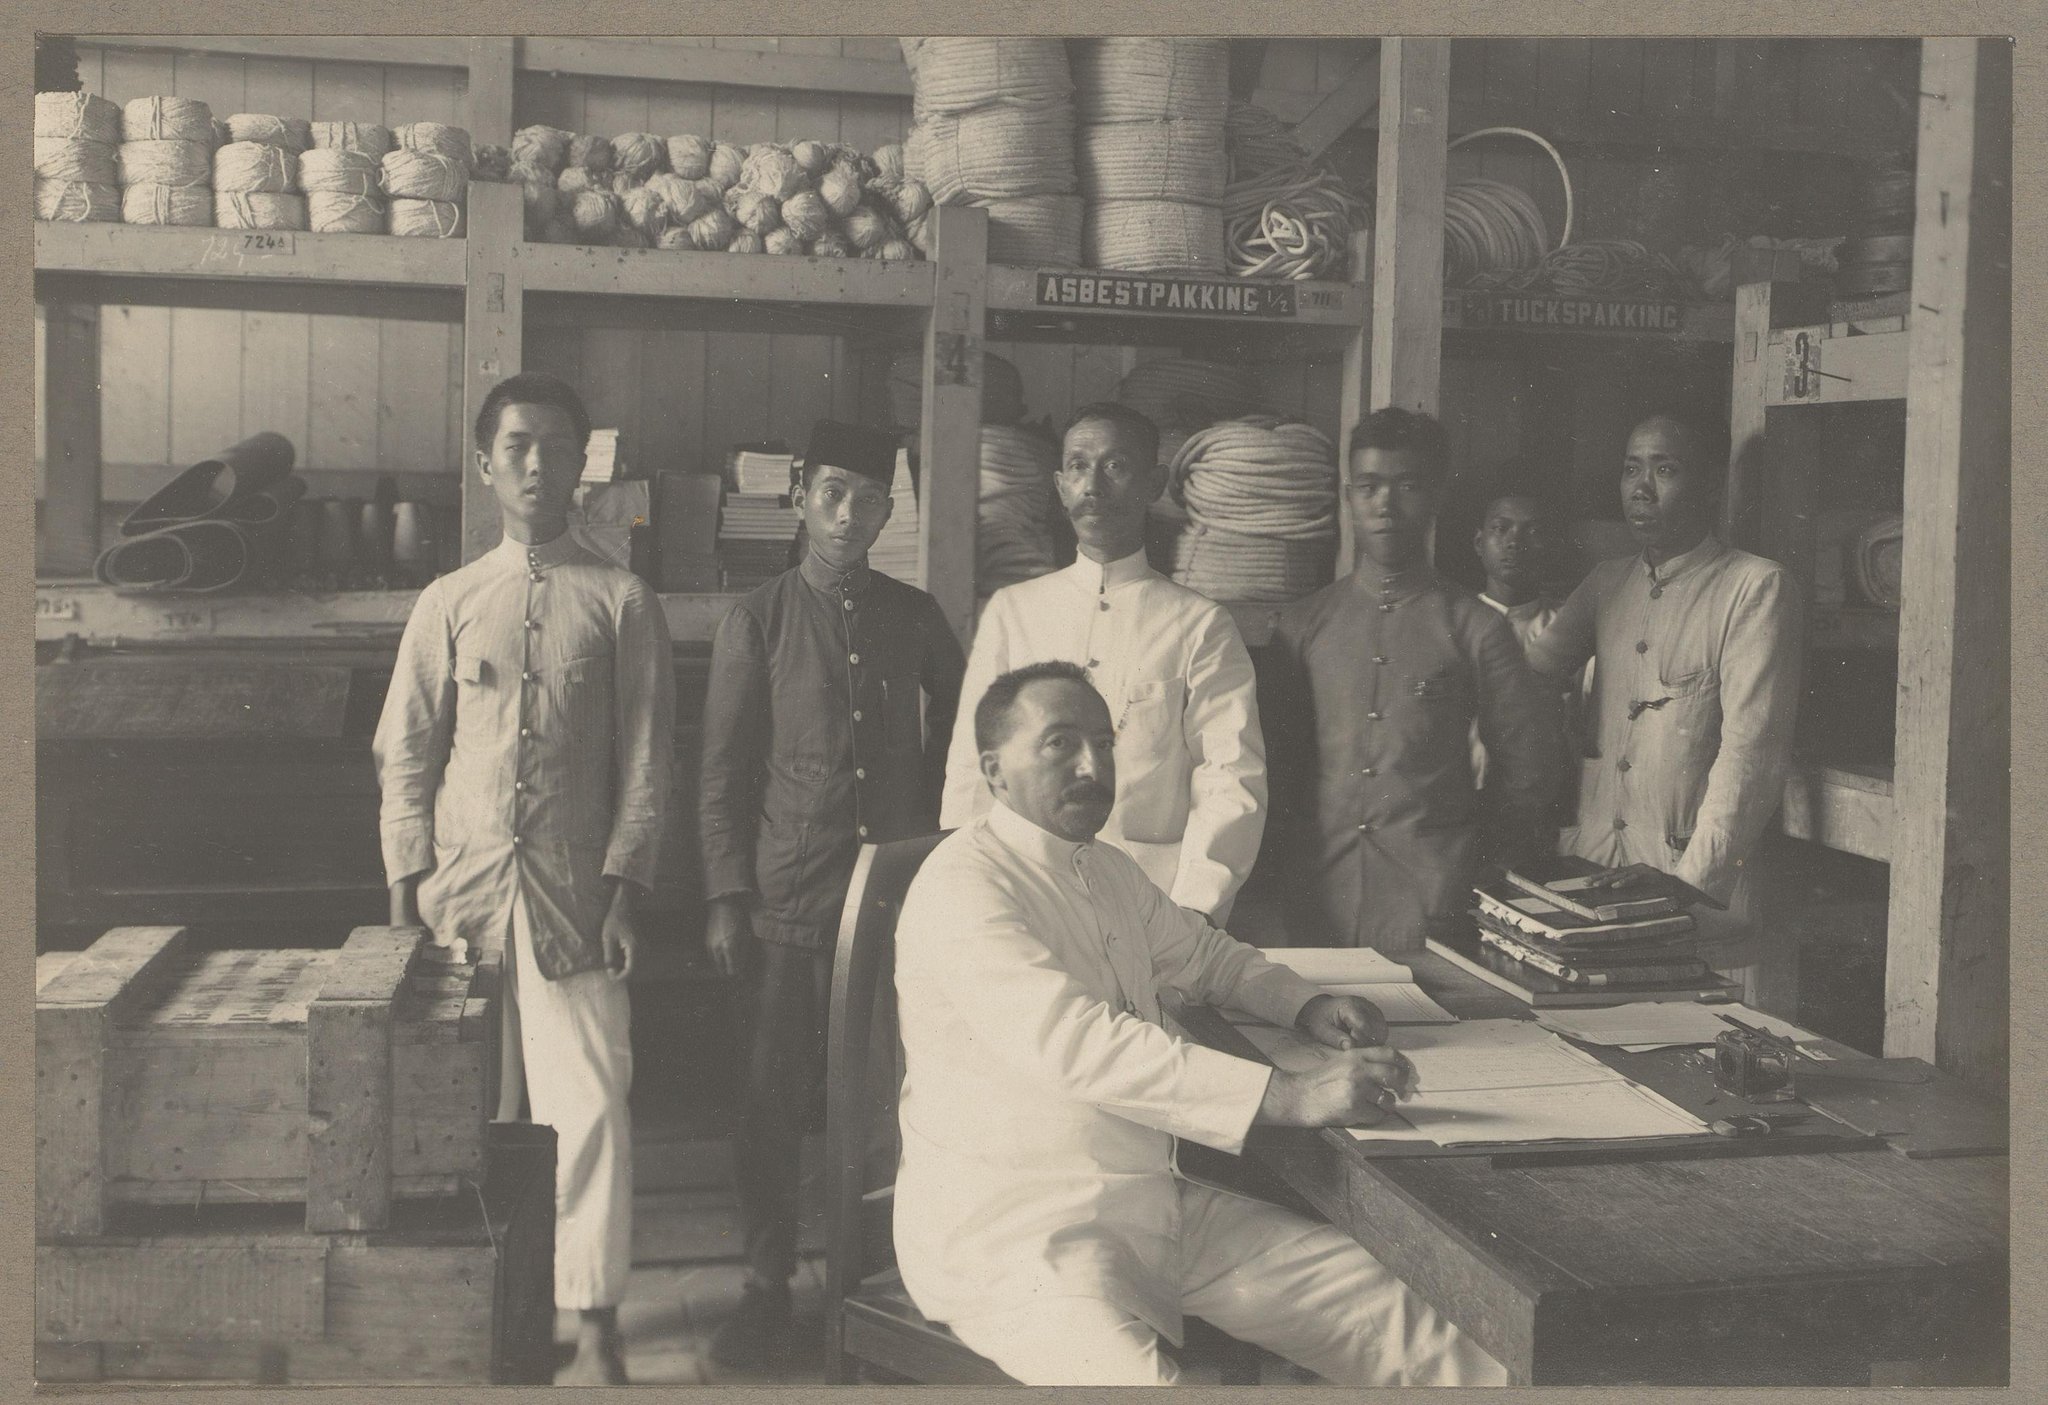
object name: photograph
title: Pangkalpinang. Bureau van den Magazijnmeester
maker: Anonymous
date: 1914-1919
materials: photographic support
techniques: gelatin silver print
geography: bangka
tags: robert julius boers, colonial system, mining, office (~ administration)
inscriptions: inscription: ‘Pangkalpinang. Bureau van den Magazijnmeester’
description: Groepsfoto van de magazijnmeester en personeel van het magazijn van de Banka-tinwinning te Pangkalpinang. Onderdeel van het fotoalbum aangeboden aan Robert Julius Boers bij zijn vertrek naar Nederland in 1919 door het personeel van de Banka-tinwinning.